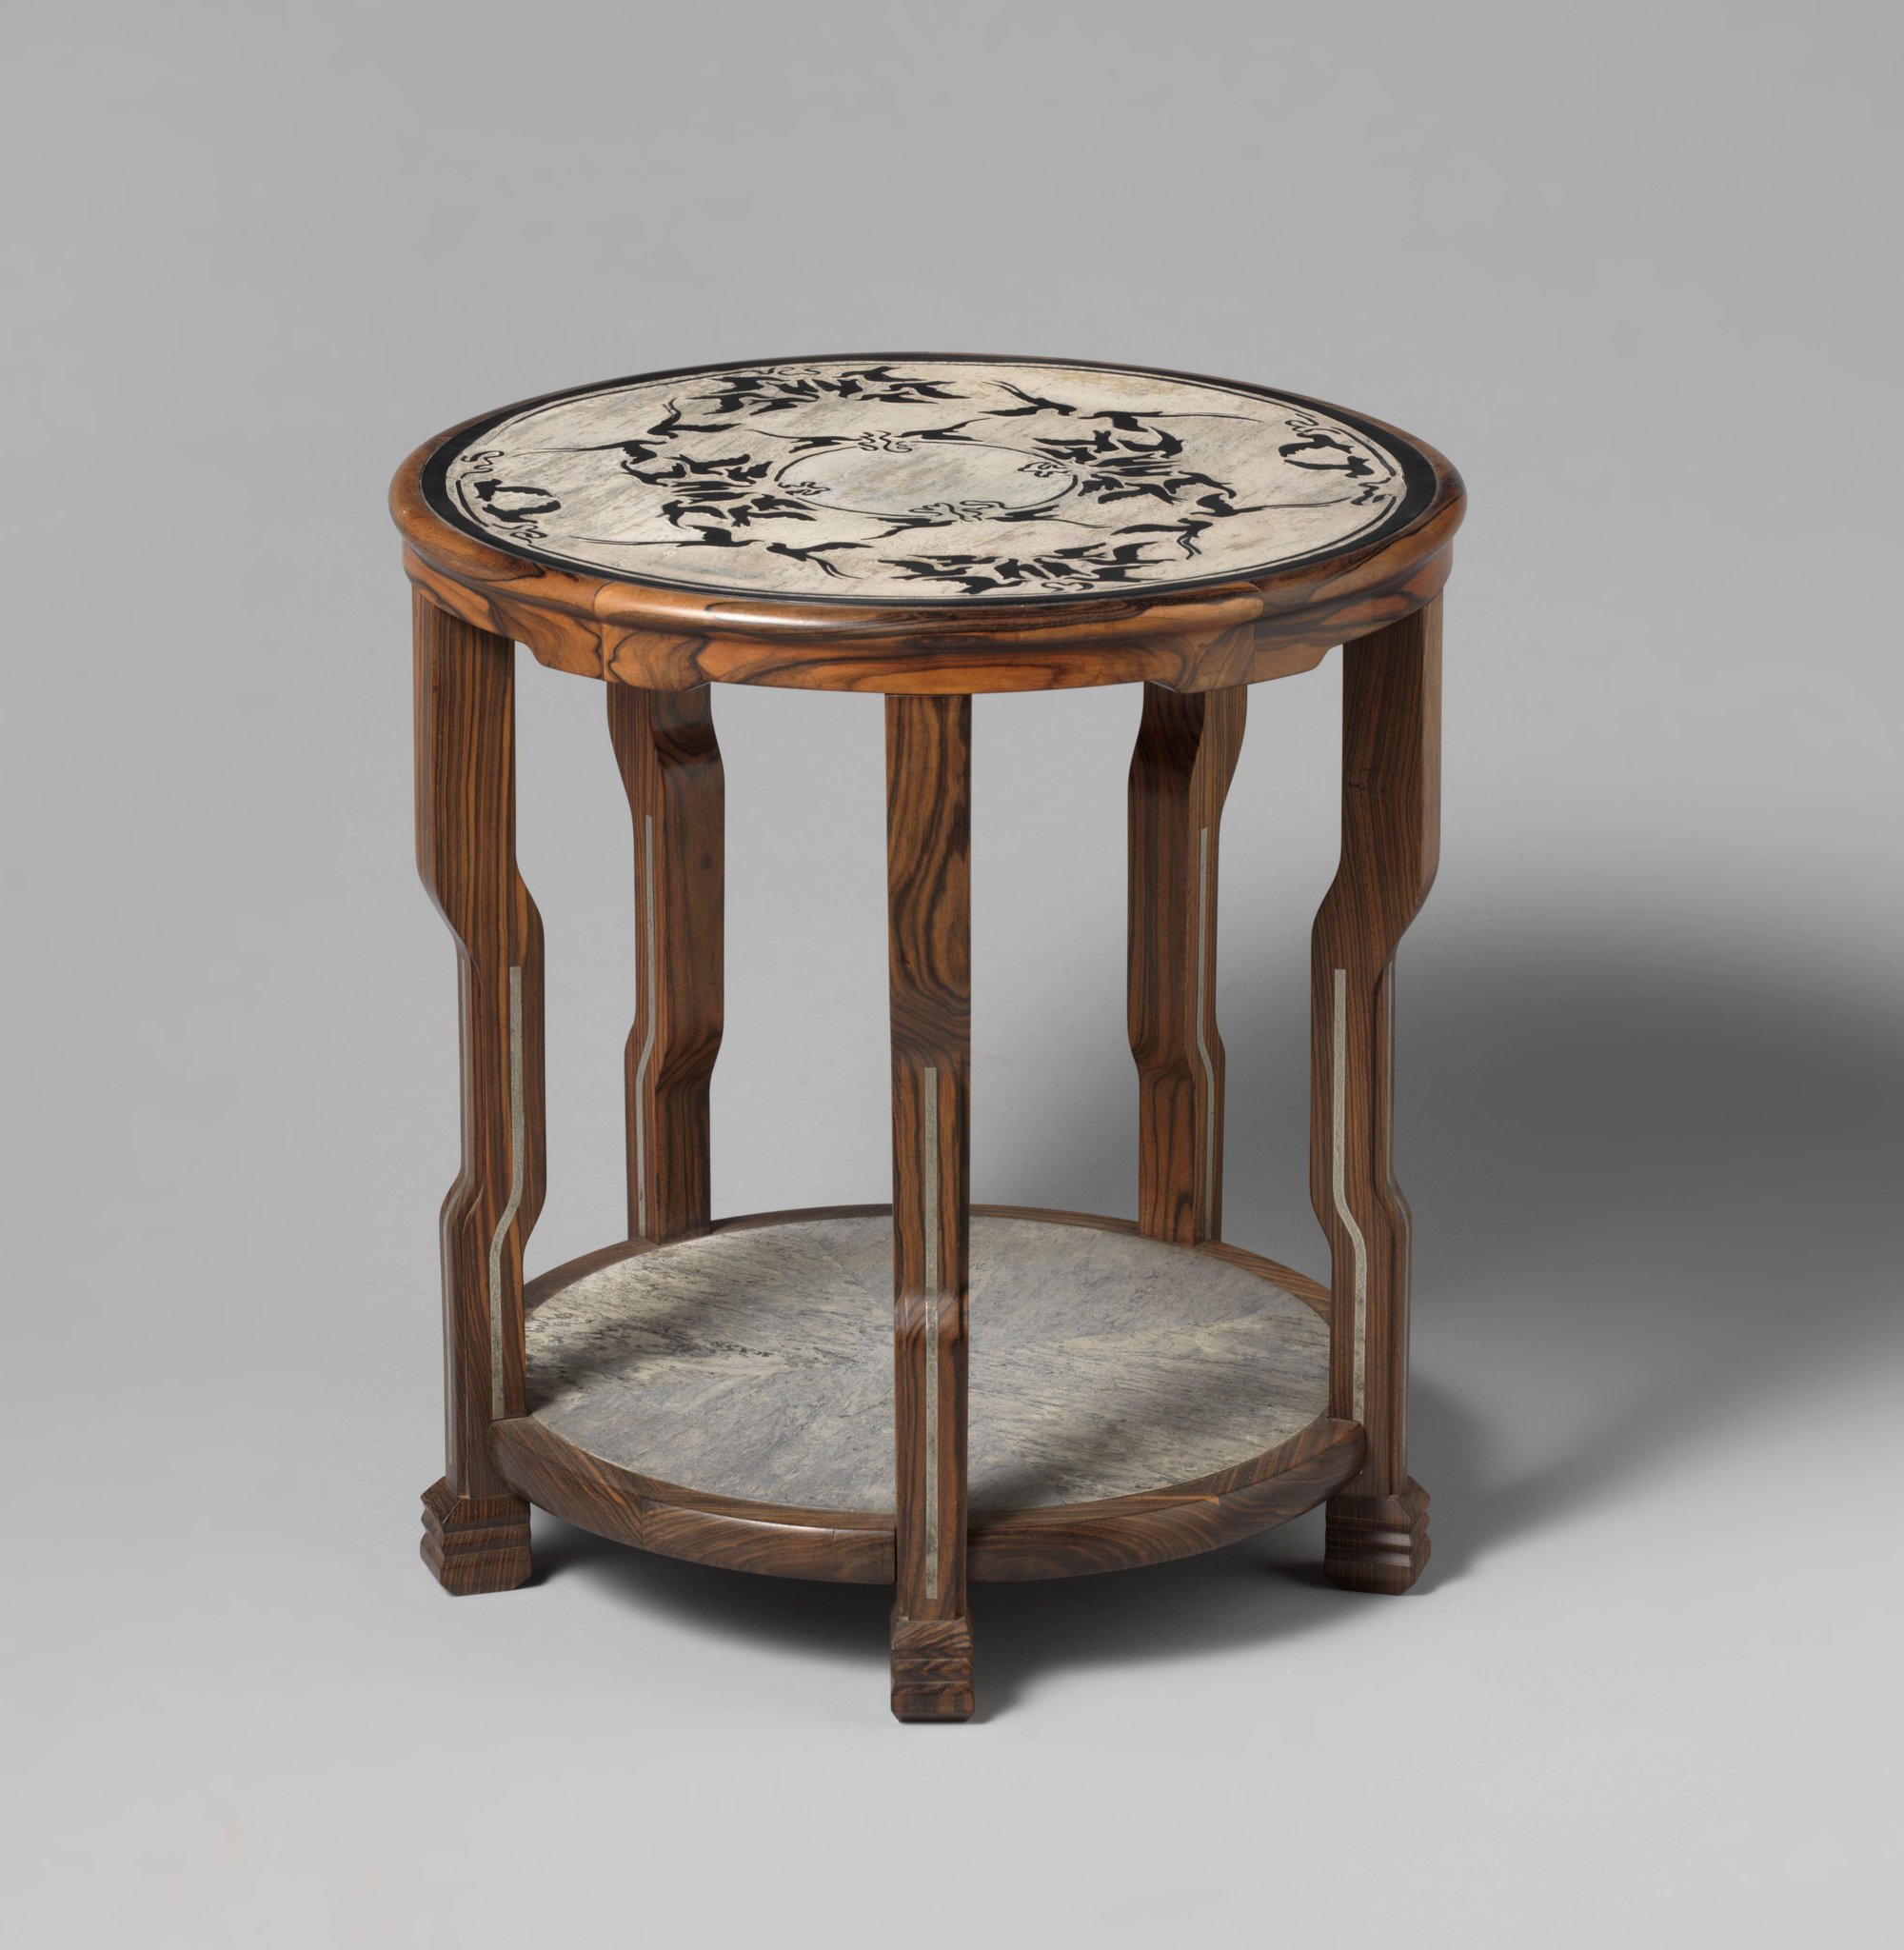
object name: table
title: Tafel van coromandelhout en ebbenhout, ingelegd met tinnen biezen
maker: carel adolph lion cachet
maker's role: draughtsman, print maker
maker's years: 1864-1945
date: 1920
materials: chalk, wood, linoleum, tin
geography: northern netherlands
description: Tafel van coromandelhout en ebbenhout, ingelegd met tinnen biezen. De rand van het ronde bovenblad bestaat uit vijf gelijke segmenten met een afgeronde bovenrand en een rechte wand. Waar de segmenten elkaar raken zijn ze aan de onderkant uitgeschulpt. De vijf hoge poten met tinnen bies zijn ter halver hoogte naar binnen gebogen, rusten op klossen en zijn even daarboven door een blad verbonden. Het onderblad is belegd met linoleum; het bovenblad vertoont symmetrisch geplaatste vogels en gebogen lijnen van ebbenhout, de ruimte er omheen is uitgegrond en gevuld met een witte massa